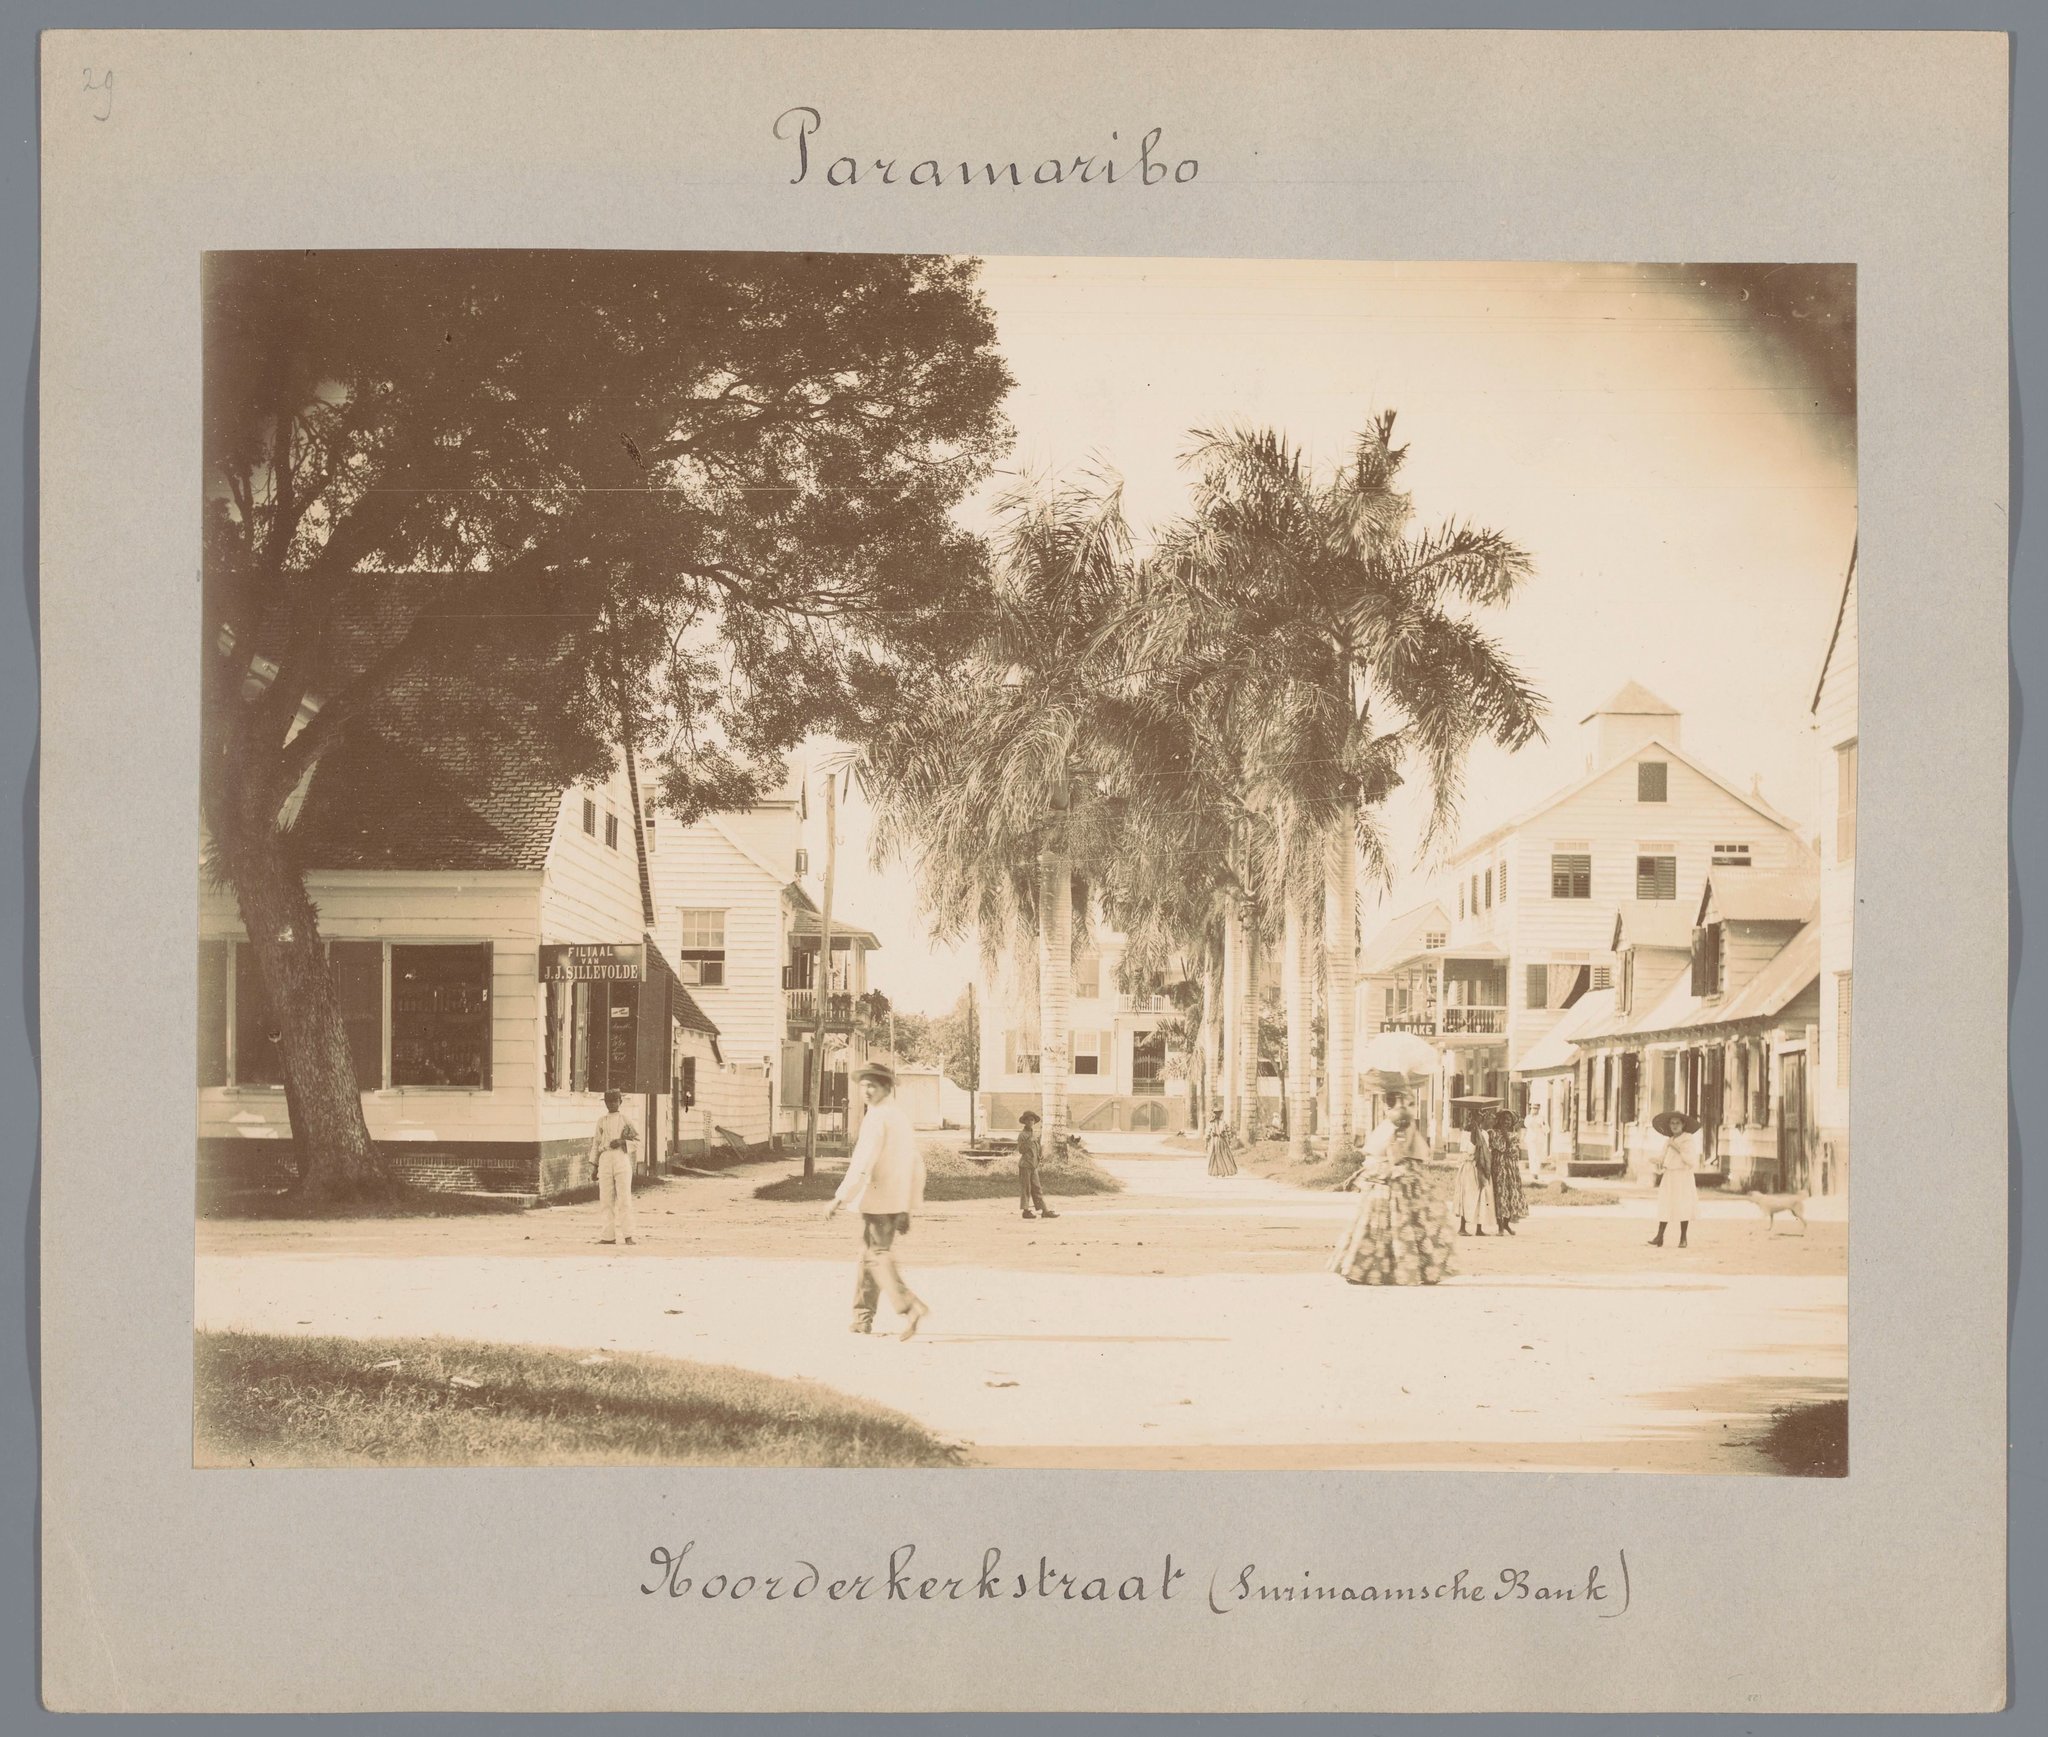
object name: photograph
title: Noorderkerkstraat (Surinaamsche Bank)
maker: eugen klein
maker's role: fotograaf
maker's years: 1869-1927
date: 1900-1905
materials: cardboard, photographic support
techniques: gelatin silver print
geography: paramaribo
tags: paramaribo (stad)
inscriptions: inscription: ‘Paramaribo / Noorderkerkstraat (Surinaamsche Bank)’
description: Gezicht op de Noorderkerkstraat en de Surinaamse Bank te Paramaribo. Onderdeel van een groep van 44 foto's van Paramaribo, Suriname en Curaçao, ca. 1900-1905, opgeplakt op kartons en voorzien van opschriften.